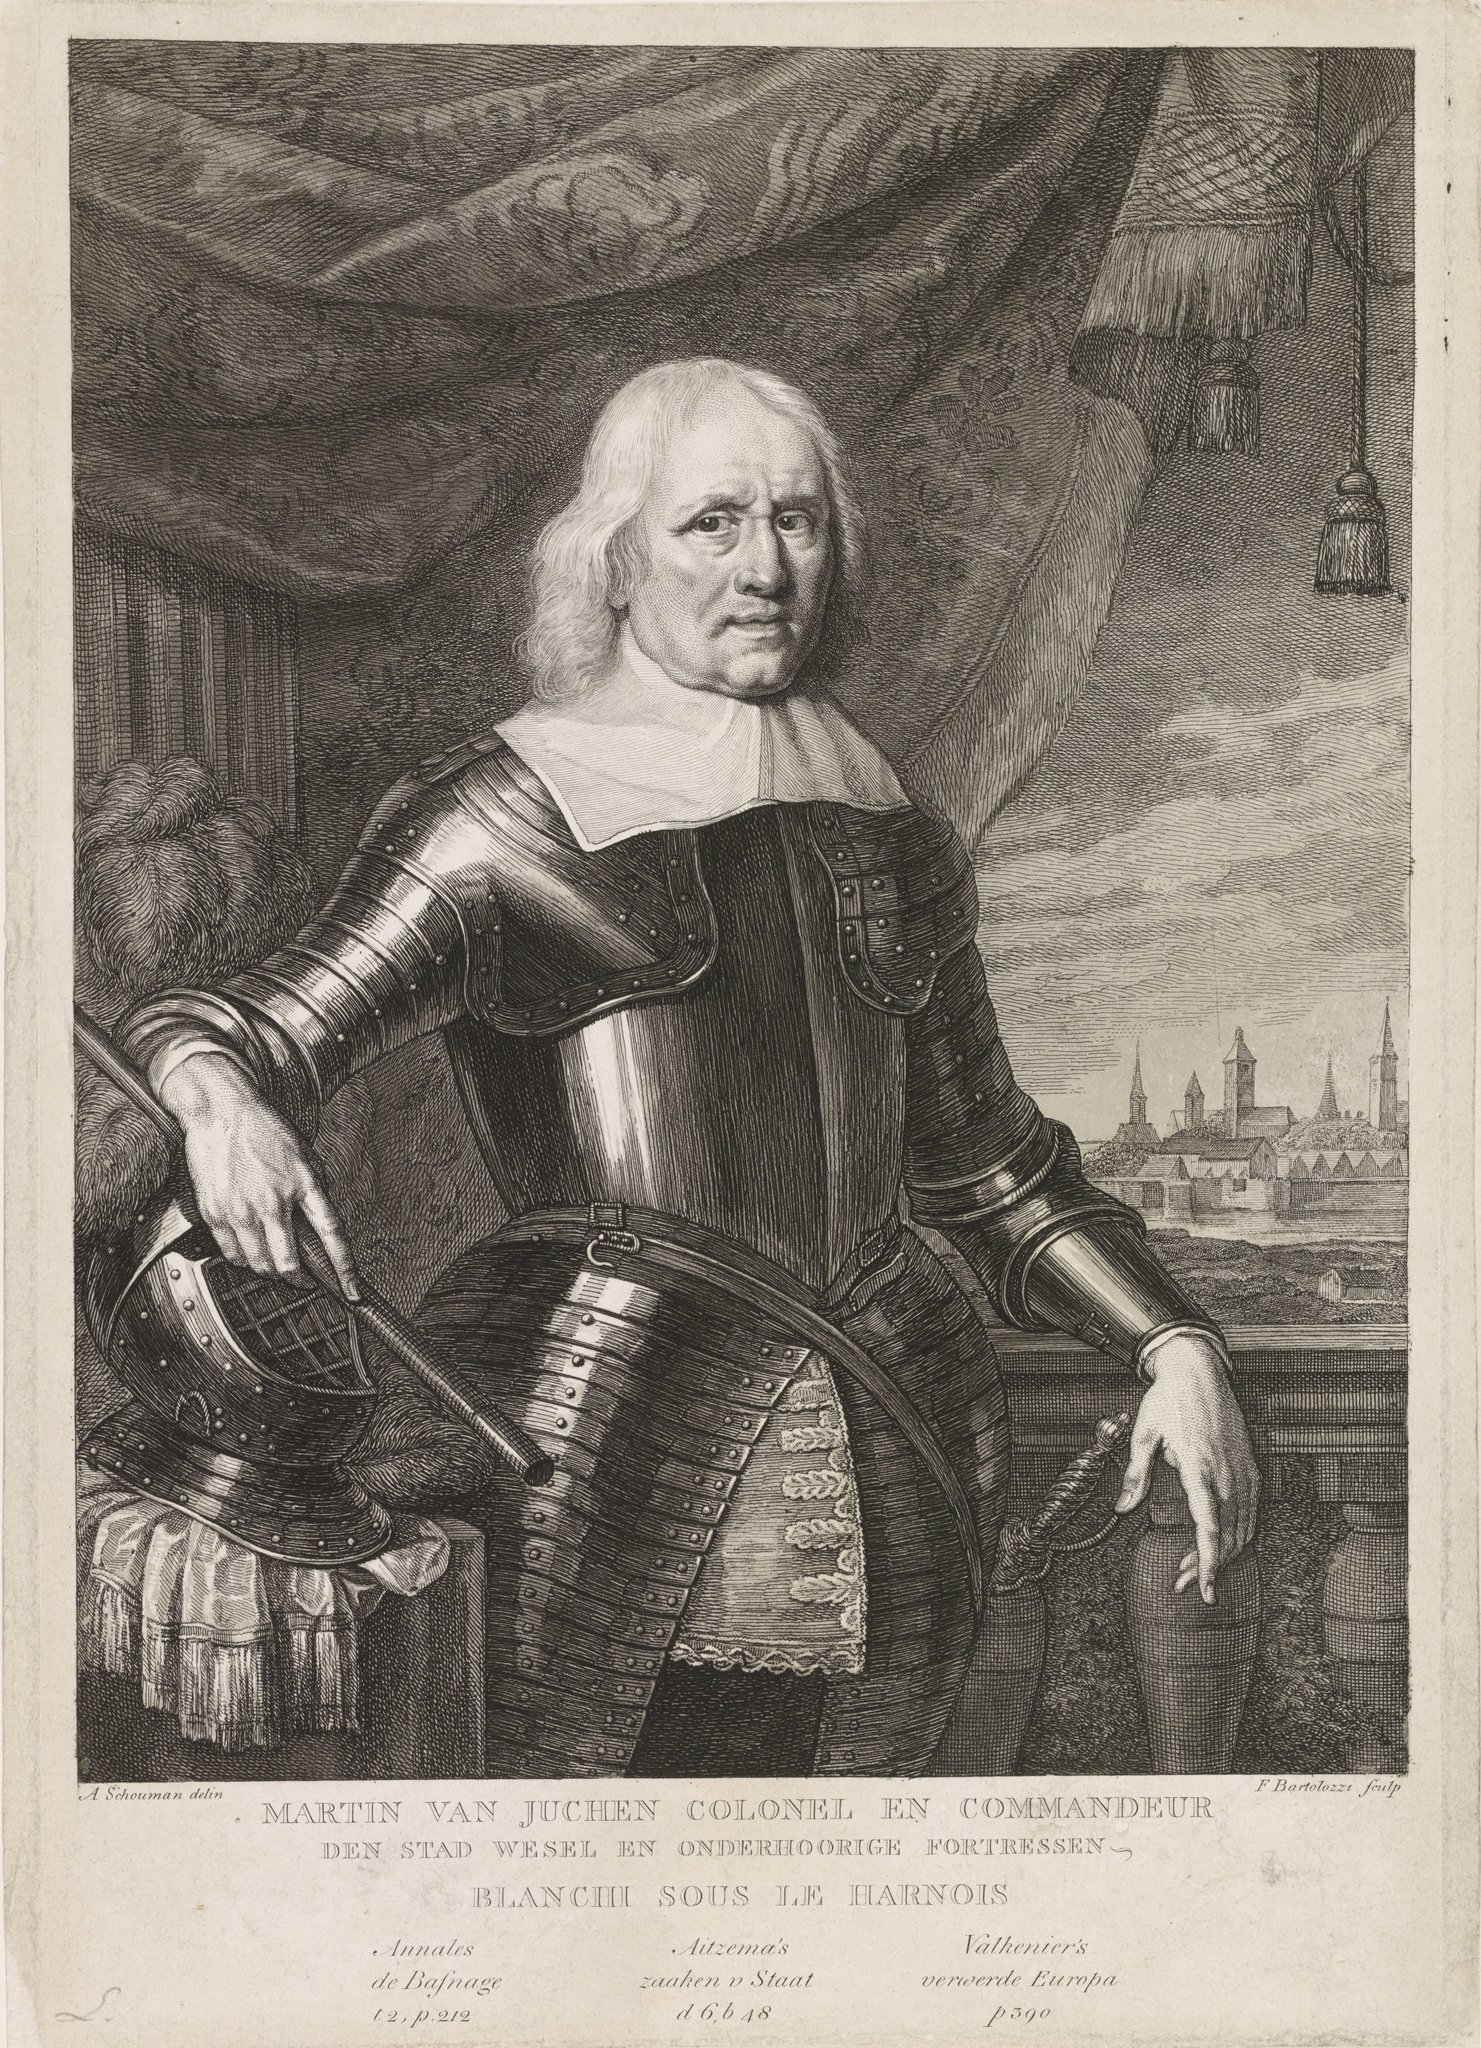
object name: print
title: Portret van Martin van Juchen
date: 1738-1815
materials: paper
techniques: engraving, etching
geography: italy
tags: historical persons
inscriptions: collector's mark: Lugt 2228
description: Portret van Martin van Juchen. Tekst in het Frans in de ondermarge.